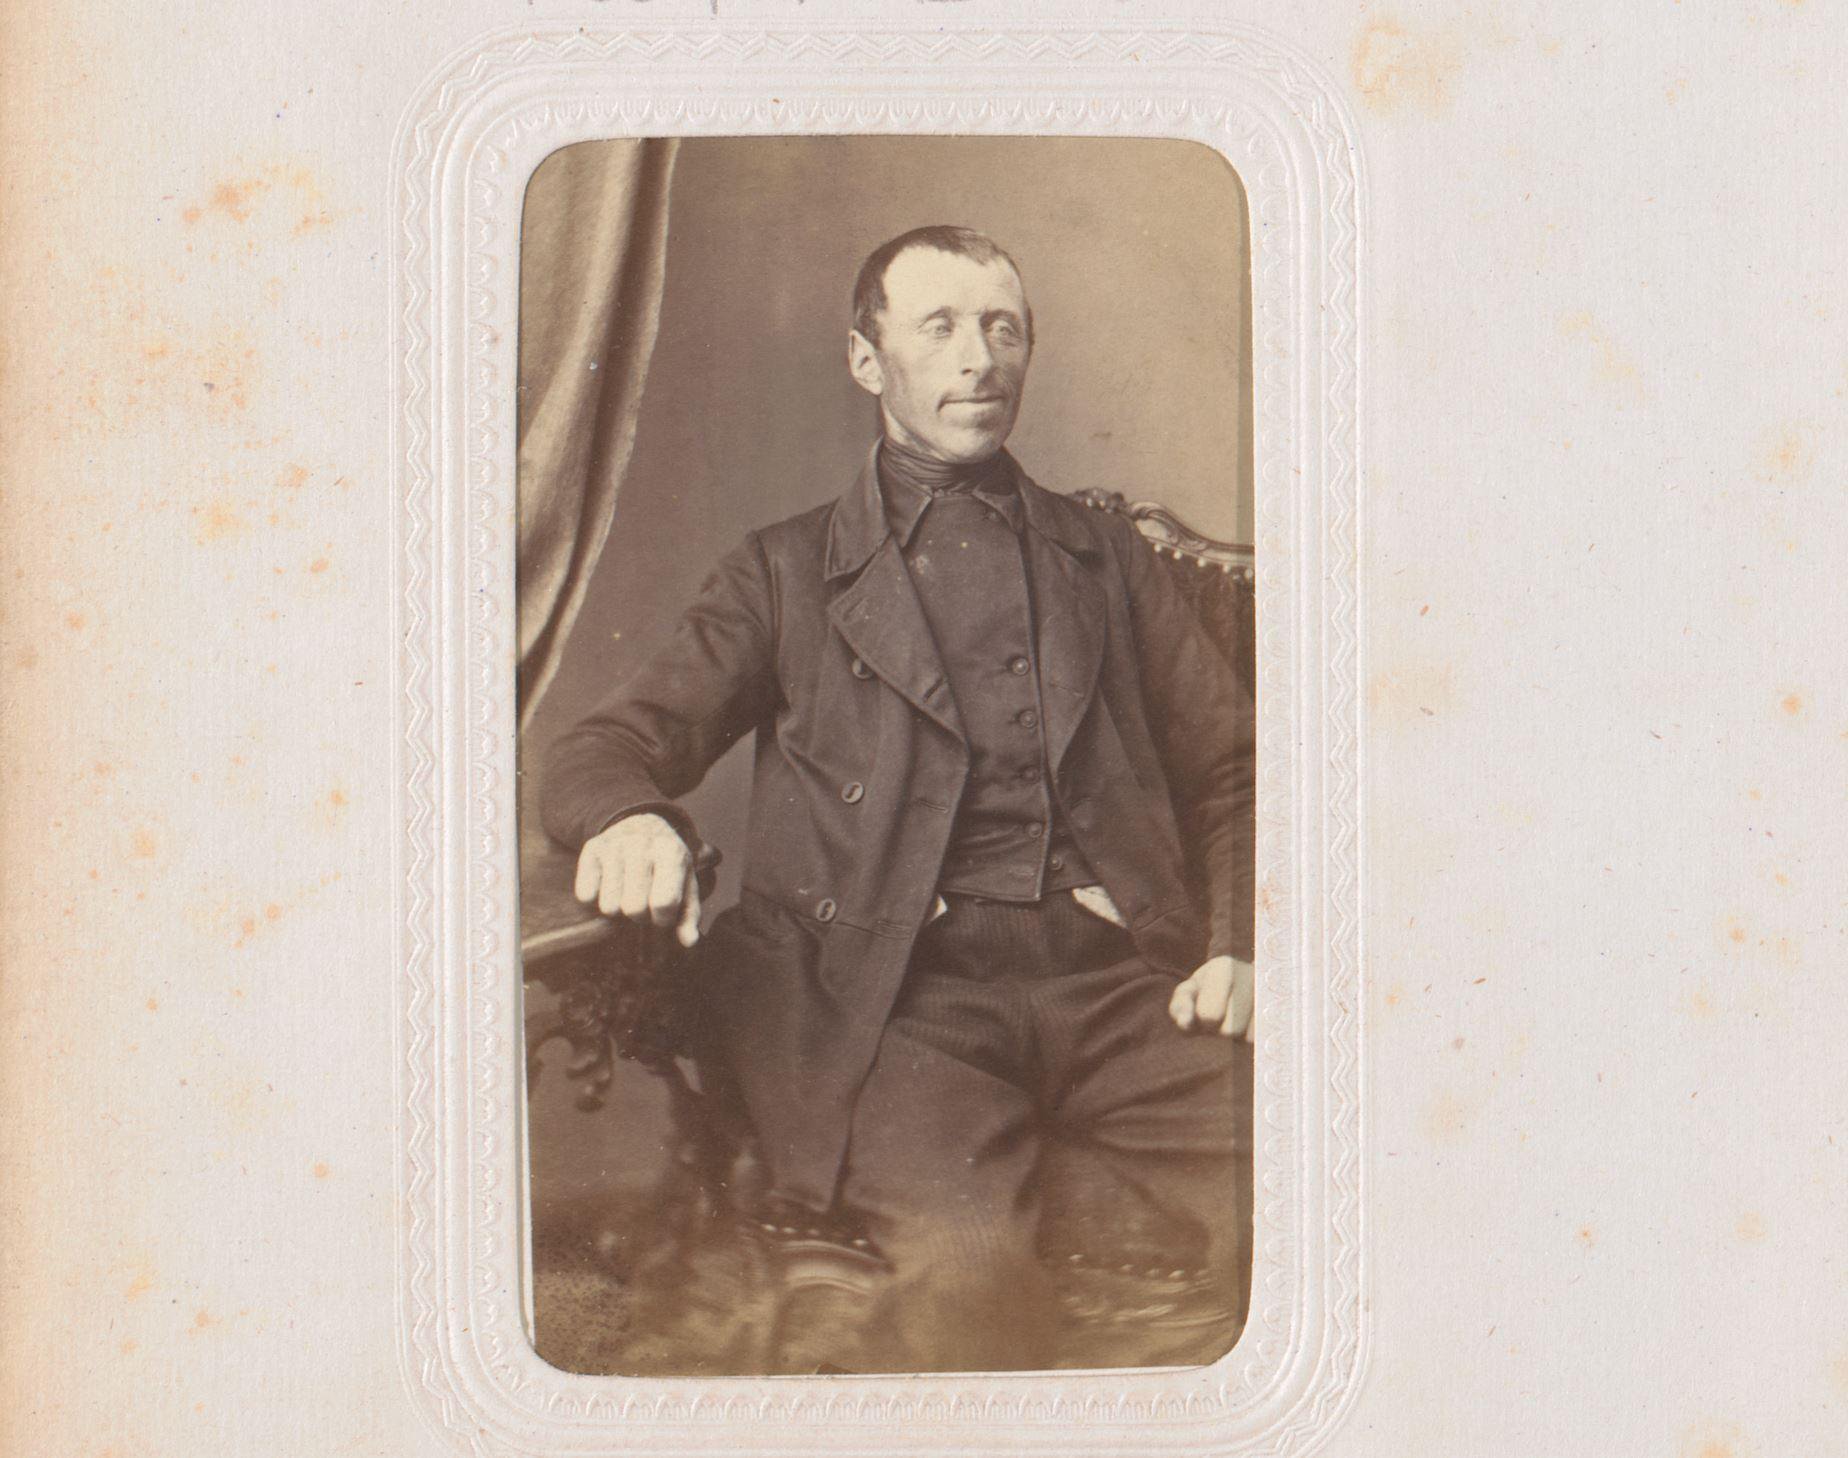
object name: photograph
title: Portret een zittende man, aangeduid als Tuk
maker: kornelis willem schorteldoek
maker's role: boekbinder, fotograaf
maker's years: 1800-1885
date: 1855-1885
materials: cardboard, photographic support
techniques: albumen print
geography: gorinchem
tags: sitting figure, historical persons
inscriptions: annotation: ‘Tuk/ (fabriek)’, inscription: ‘SCHORTELDOEK/ PHOTOGRAAF/ GORINCHEM/ Groote Markt’